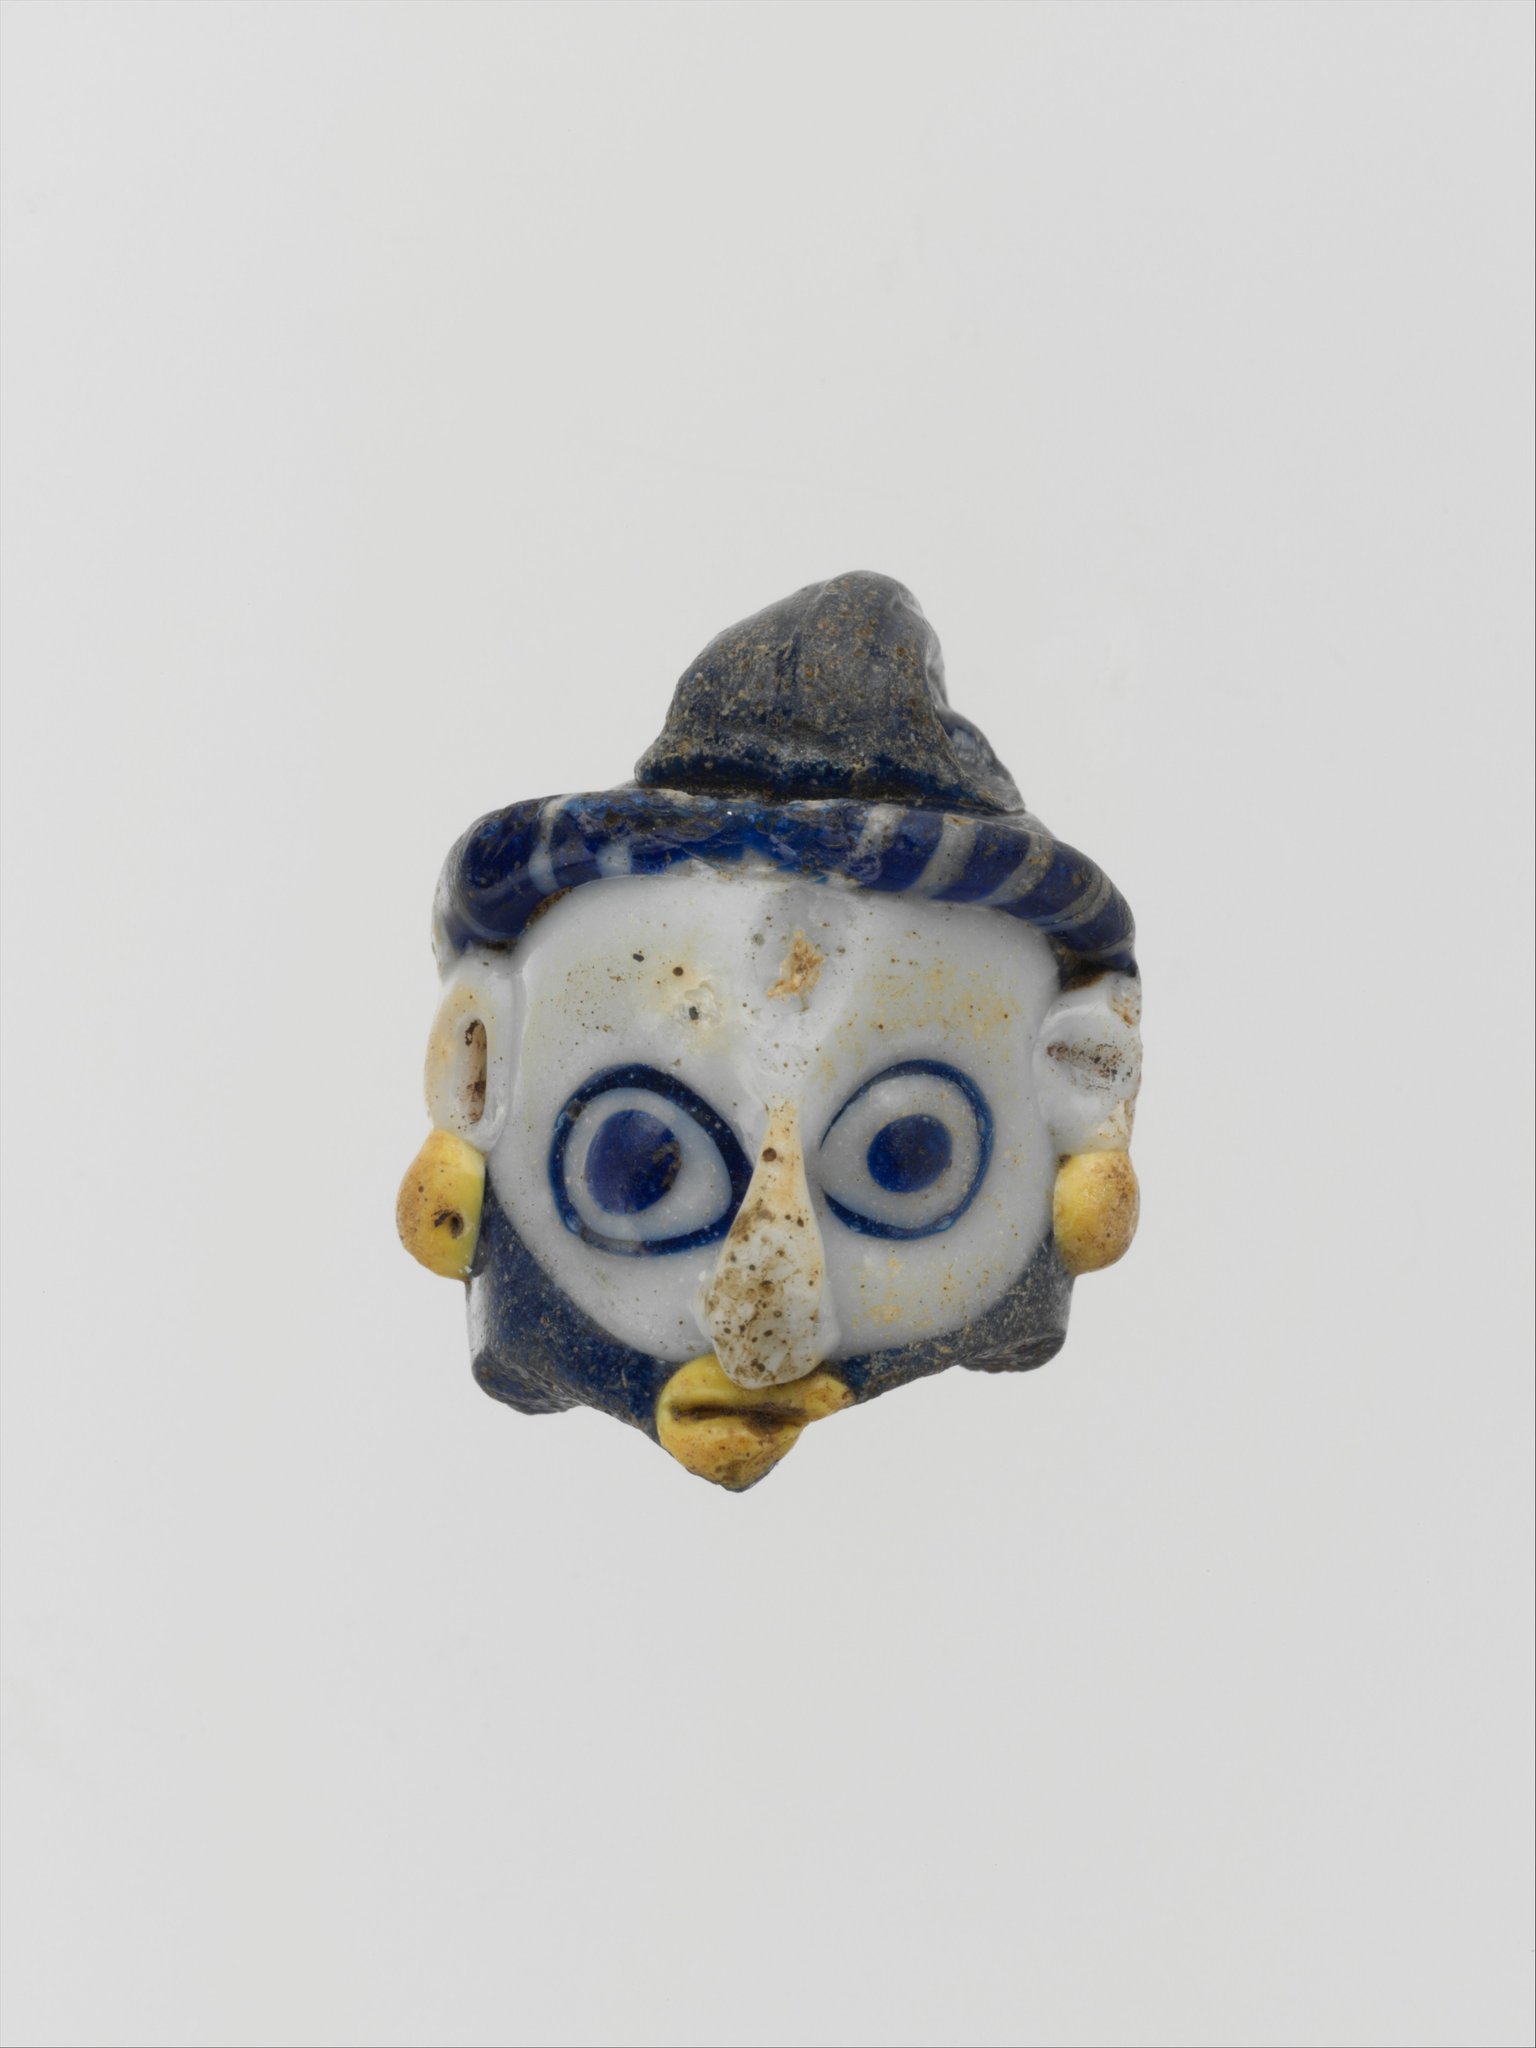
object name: head pendant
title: Glass head pendant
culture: carthaginian or phoenician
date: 367-201 BCE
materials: glass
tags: heads